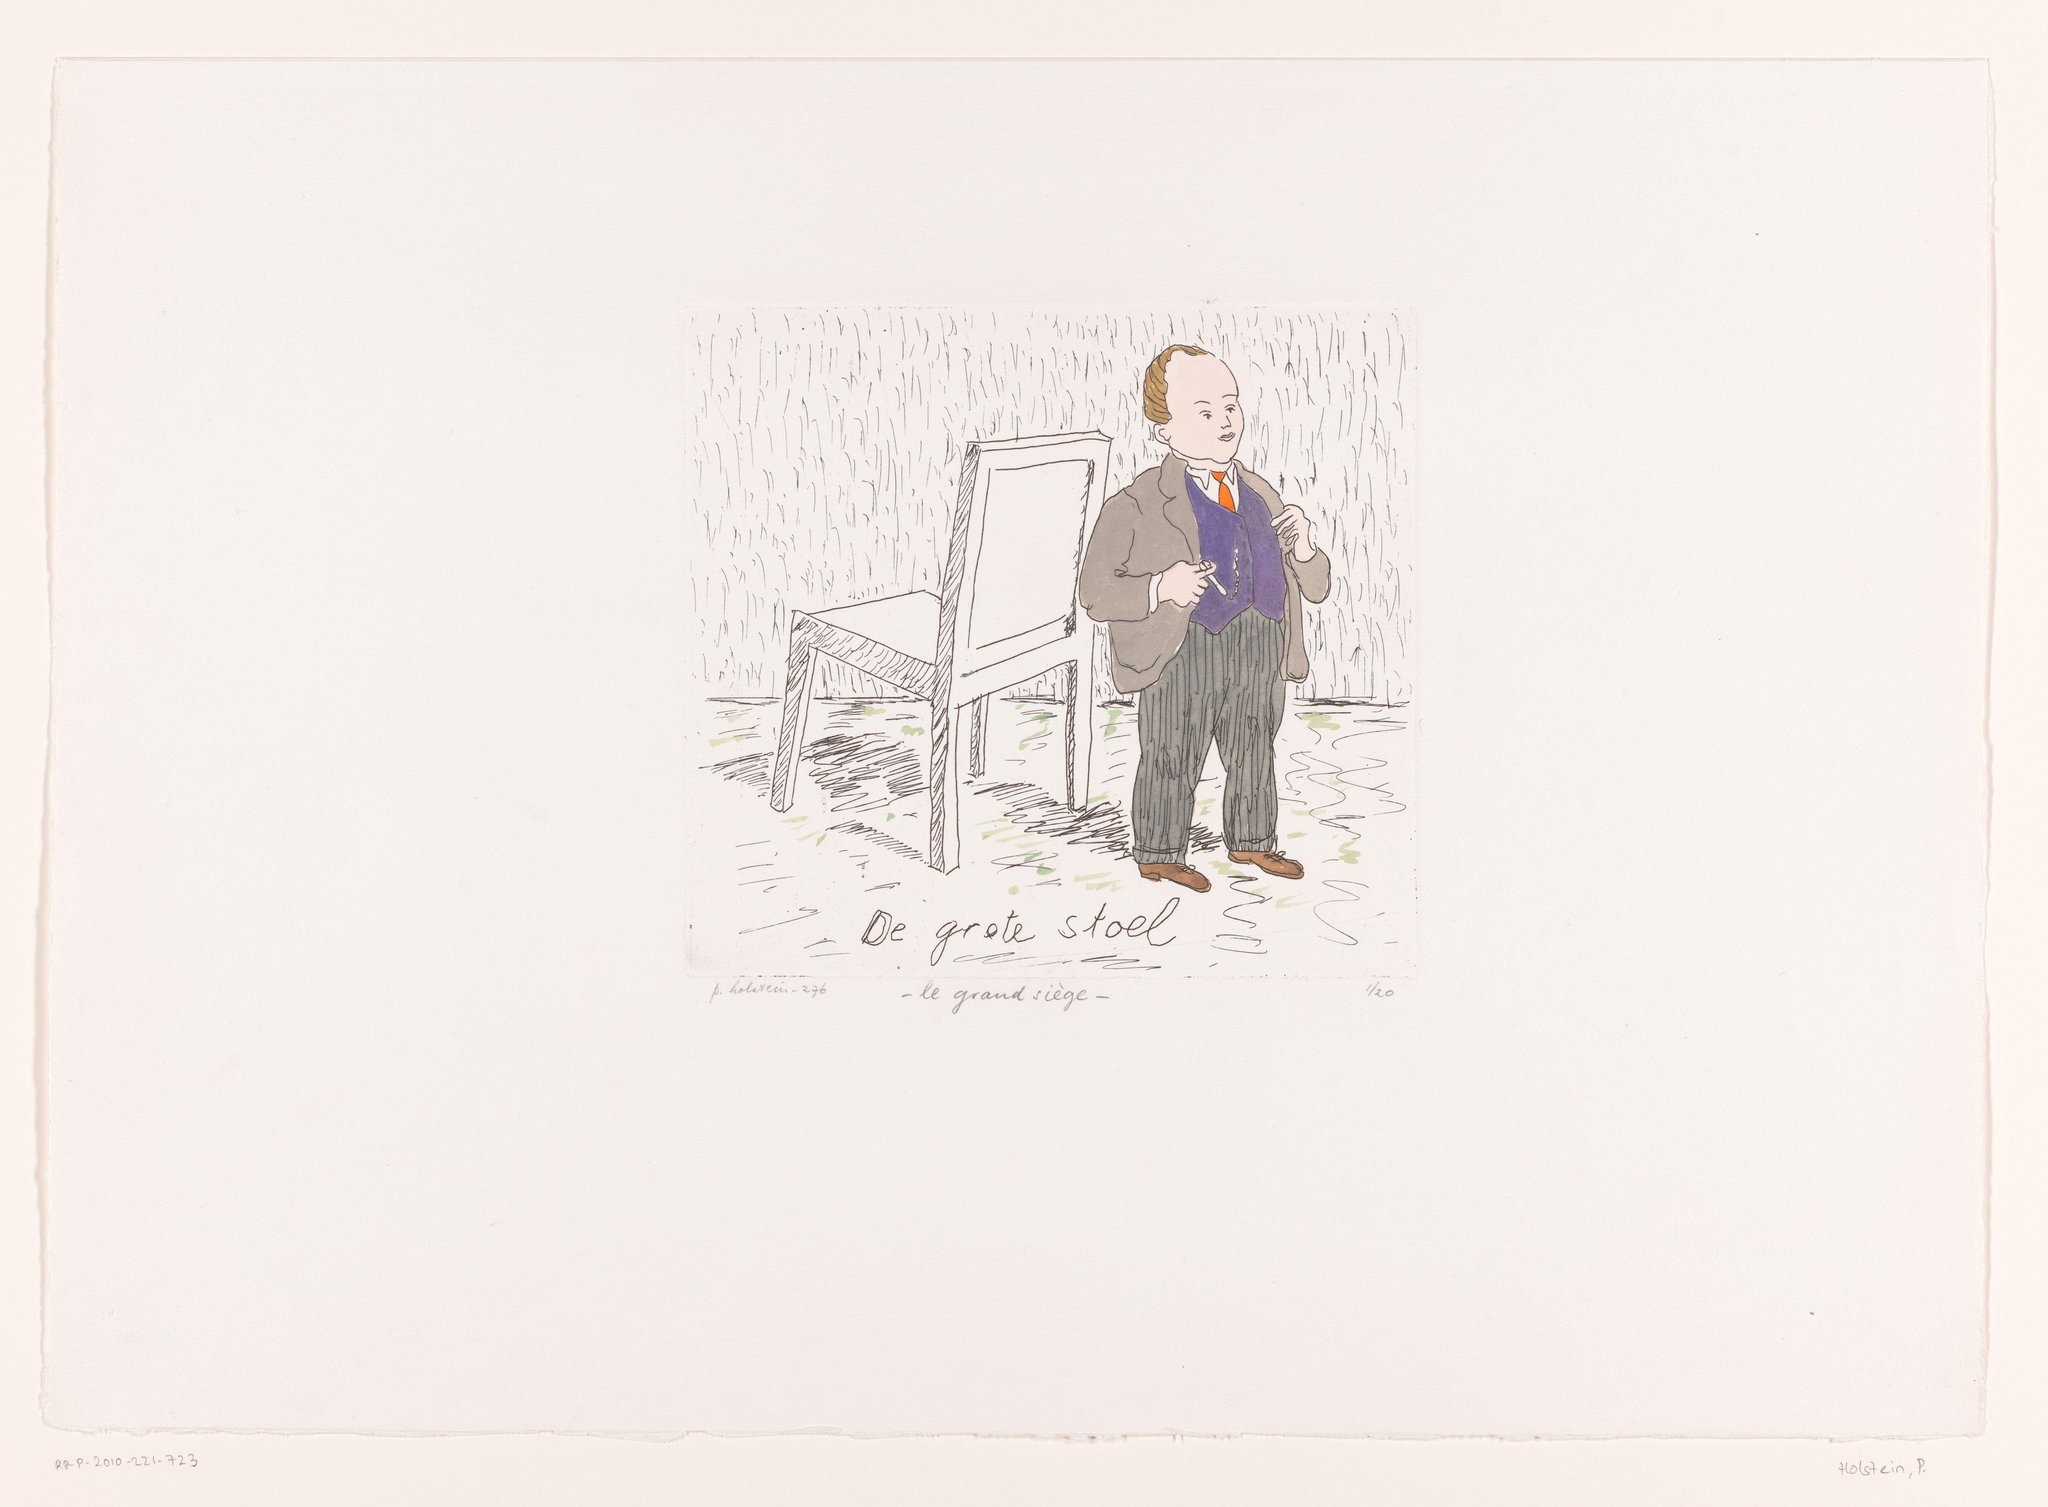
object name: print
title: De grote stoel/ Le grand siège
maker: pieter holstein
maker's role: draughtsman, painter, print maker, sculptor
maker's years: 1934-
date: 1975-1982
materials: paper, watercolor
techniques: brush, etching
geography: amsterdam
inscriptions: edition: ‘1/20’, title: ‘- le grand siège -’, title: ‘De grote stoel’, signature: ‘p. holstein’